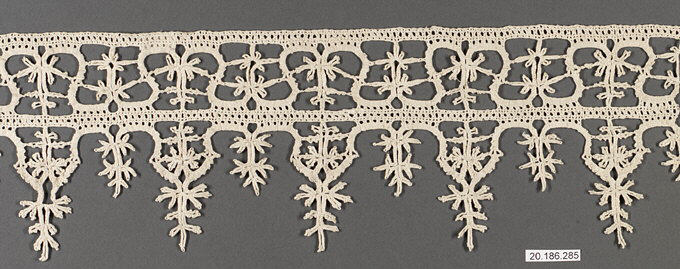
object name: edging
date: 1601-1700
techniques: lace